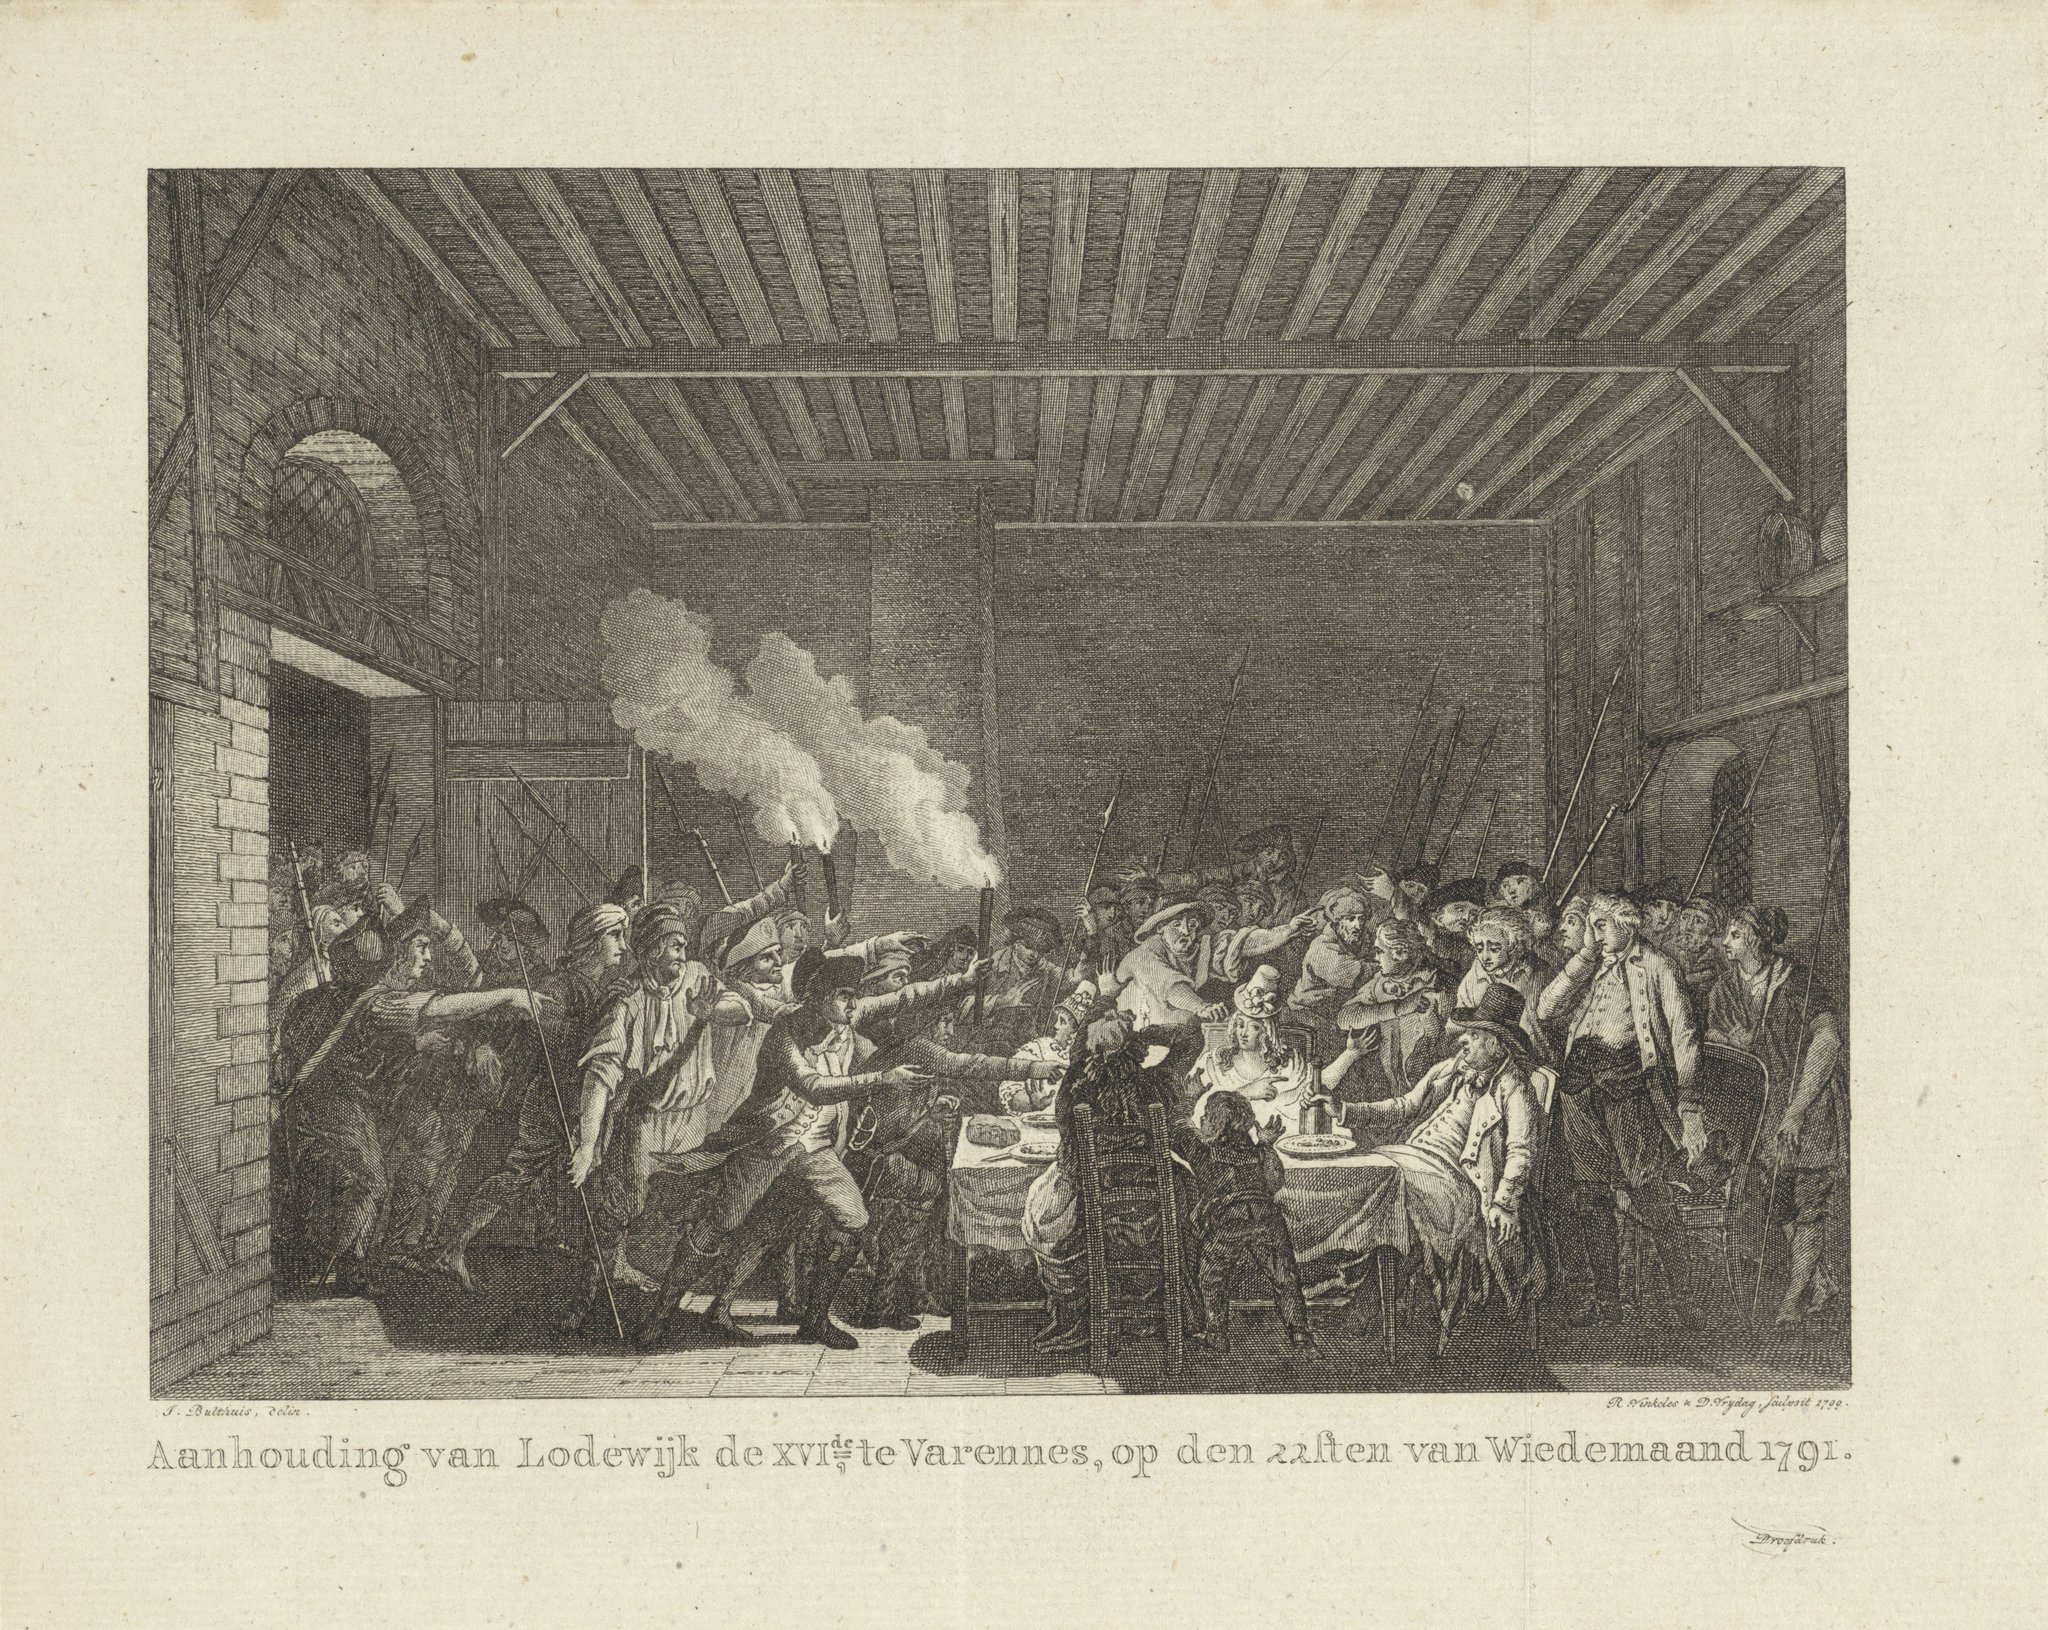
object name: history print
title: Aanhouding van Lodewijk de XVI te Varennes, 1791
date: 1799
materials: paper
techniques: engraving, etching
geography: amsterdam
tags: paris, lodewijk xvi (koning van frankrijk), arrest of fleeing ruler, revolution, revolt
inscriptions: collector's mark: Lugt 2228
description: Koning Lodewijk XVI wordt gearresteerd terwijl hij met zijn gezin tijdens de Franse Revolutie tracht te ontvluchten naar Montmédy.